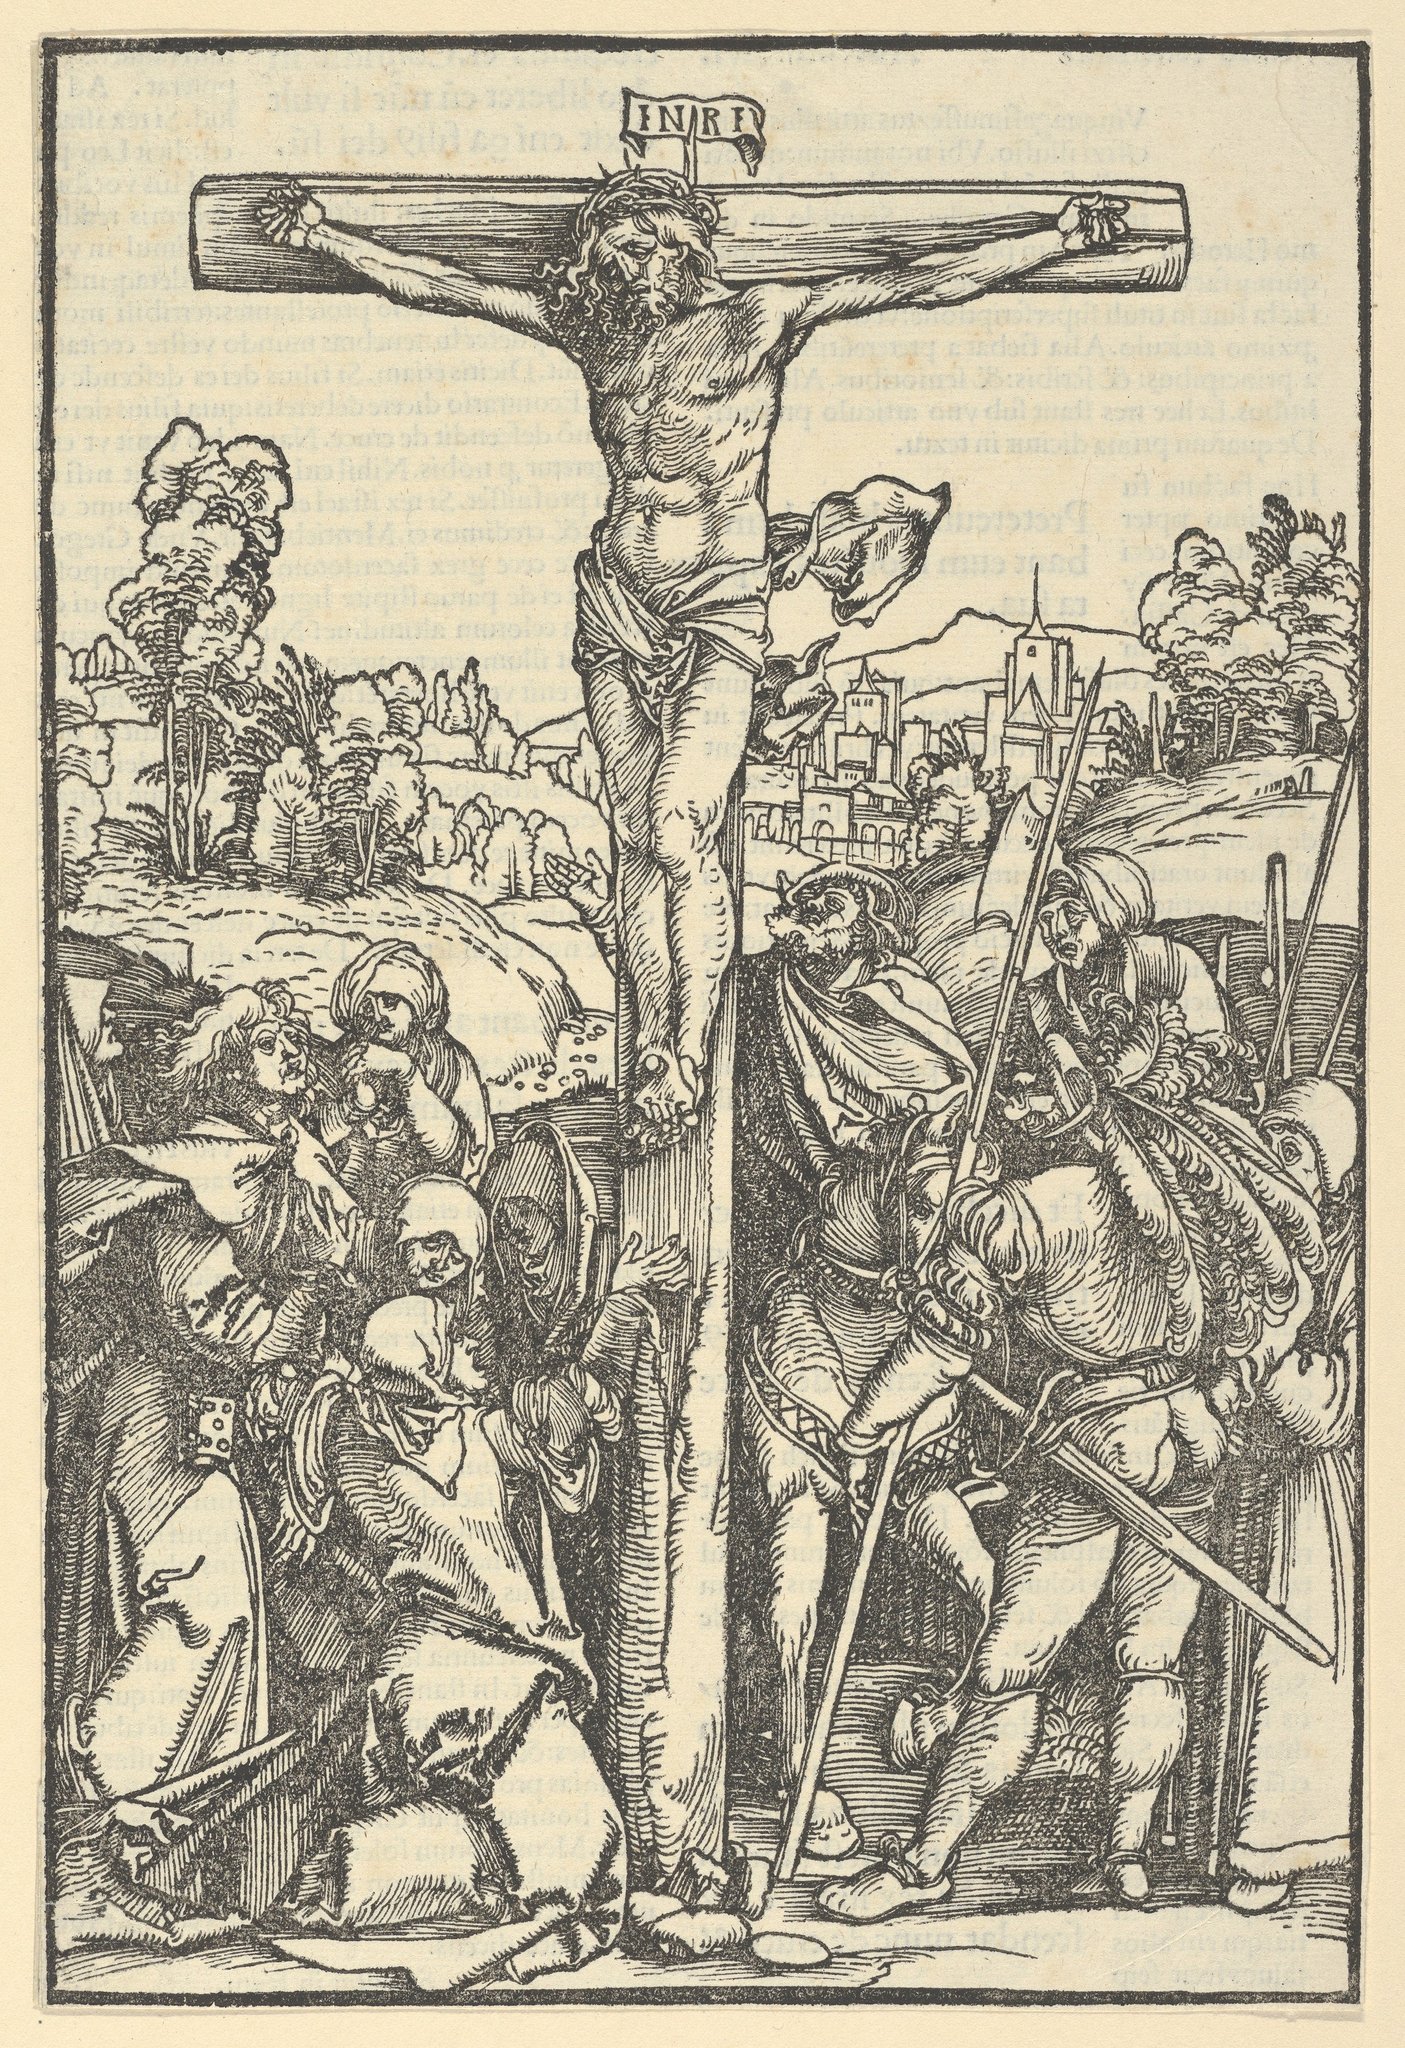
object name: print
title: The Crucifixion, from Der beschlossen gart des rosenkranzes marie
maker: hans schäufelein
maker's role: artist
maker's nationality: german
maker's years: 1480-1540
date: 1505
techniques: woodcut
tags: women,christ,crucifixion,saints